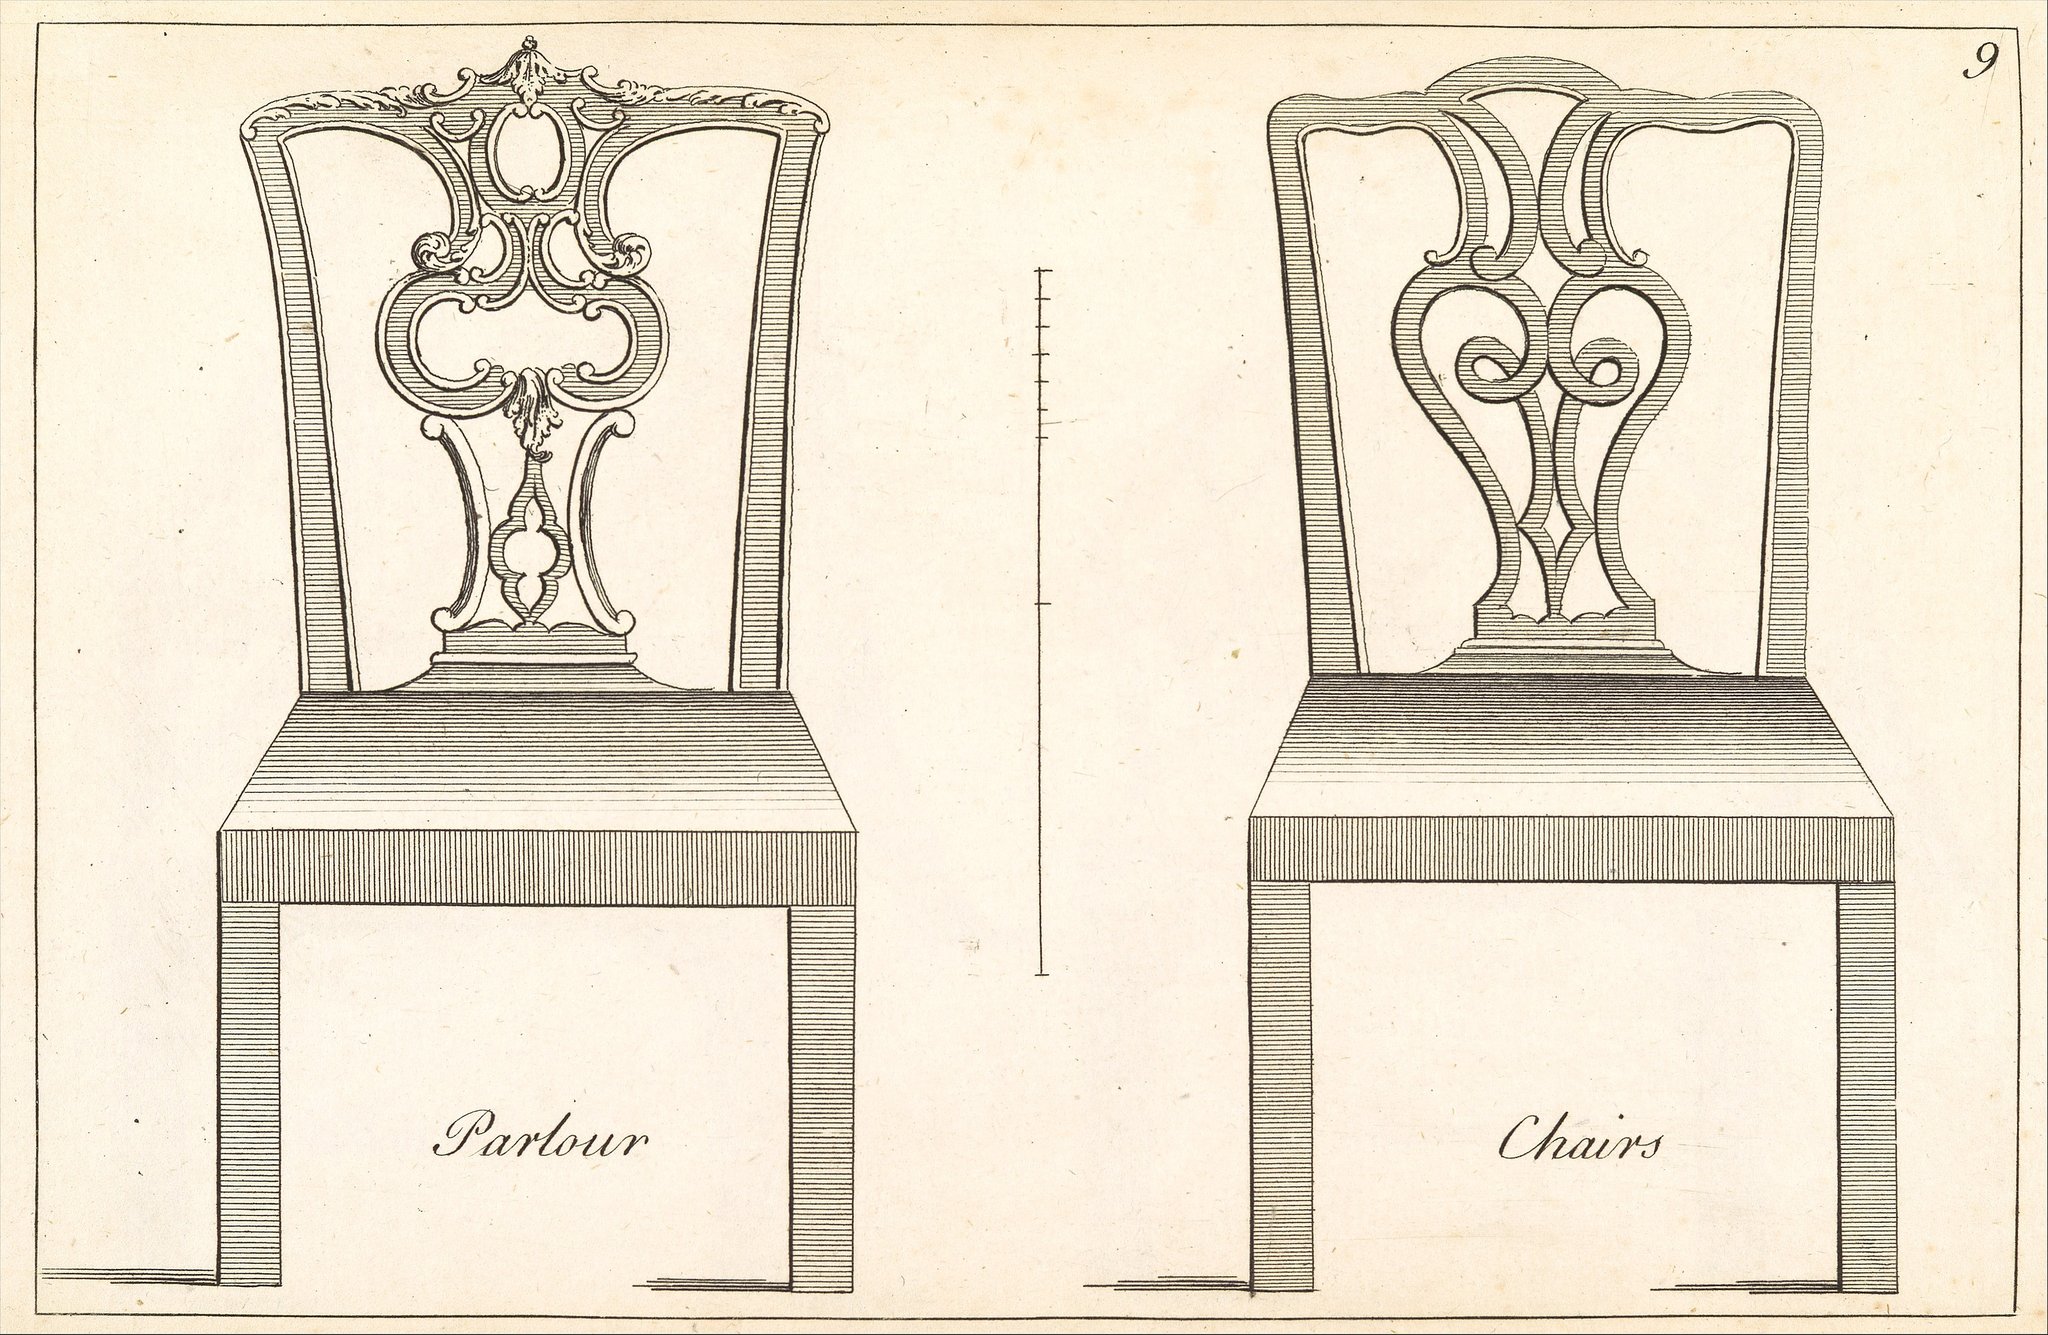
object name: book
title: The Cabinet and Chair-Maker's Real Friend and Companion, or, the Whole System of Chair-Making Made plain and easy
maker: robert manwaring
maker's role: designer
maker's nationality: british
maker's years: 1730-1800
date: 1765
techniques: engraving, etching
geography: england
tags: chairs